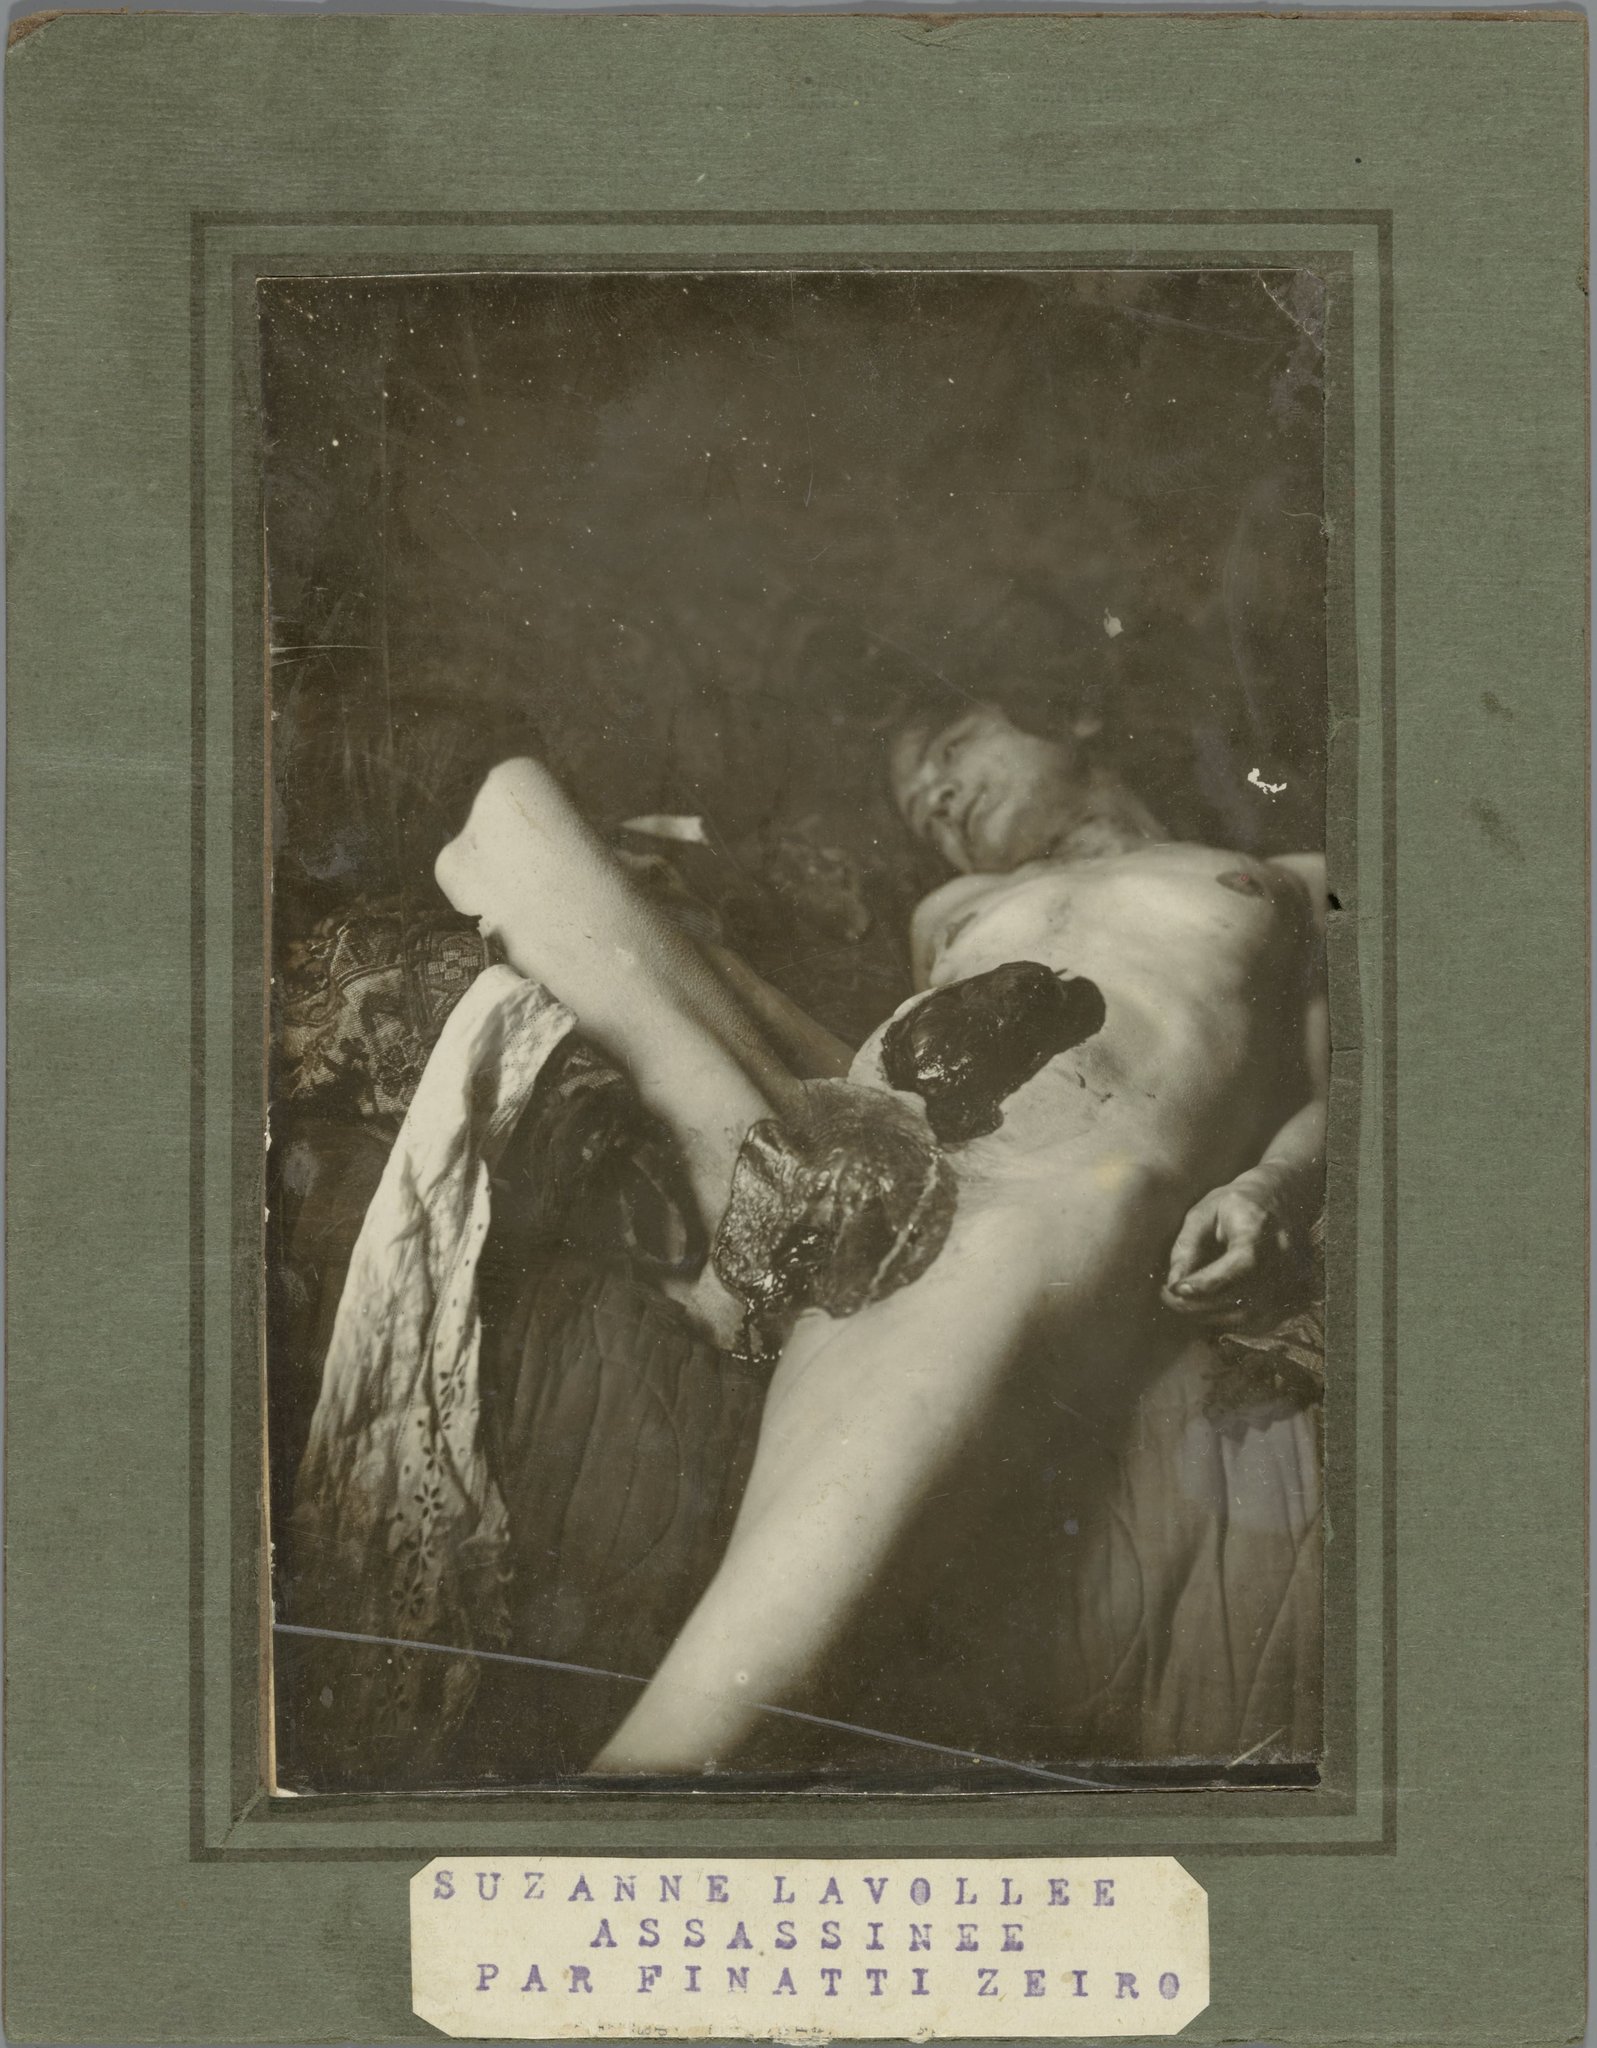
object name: photograph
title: Lijk van Suzanne Lavollée, vermoord door Francesco Zeiro Finatti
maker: Anonymous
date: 1904-1924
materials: cardboard, paper, photographic support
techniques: gelatin silver print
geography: tours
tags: violent death by mutilation or maiming, murder, the corpse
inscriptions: label: ‘Suzanne Lavollee/ Assassinee/ par Finatti Zeiro’